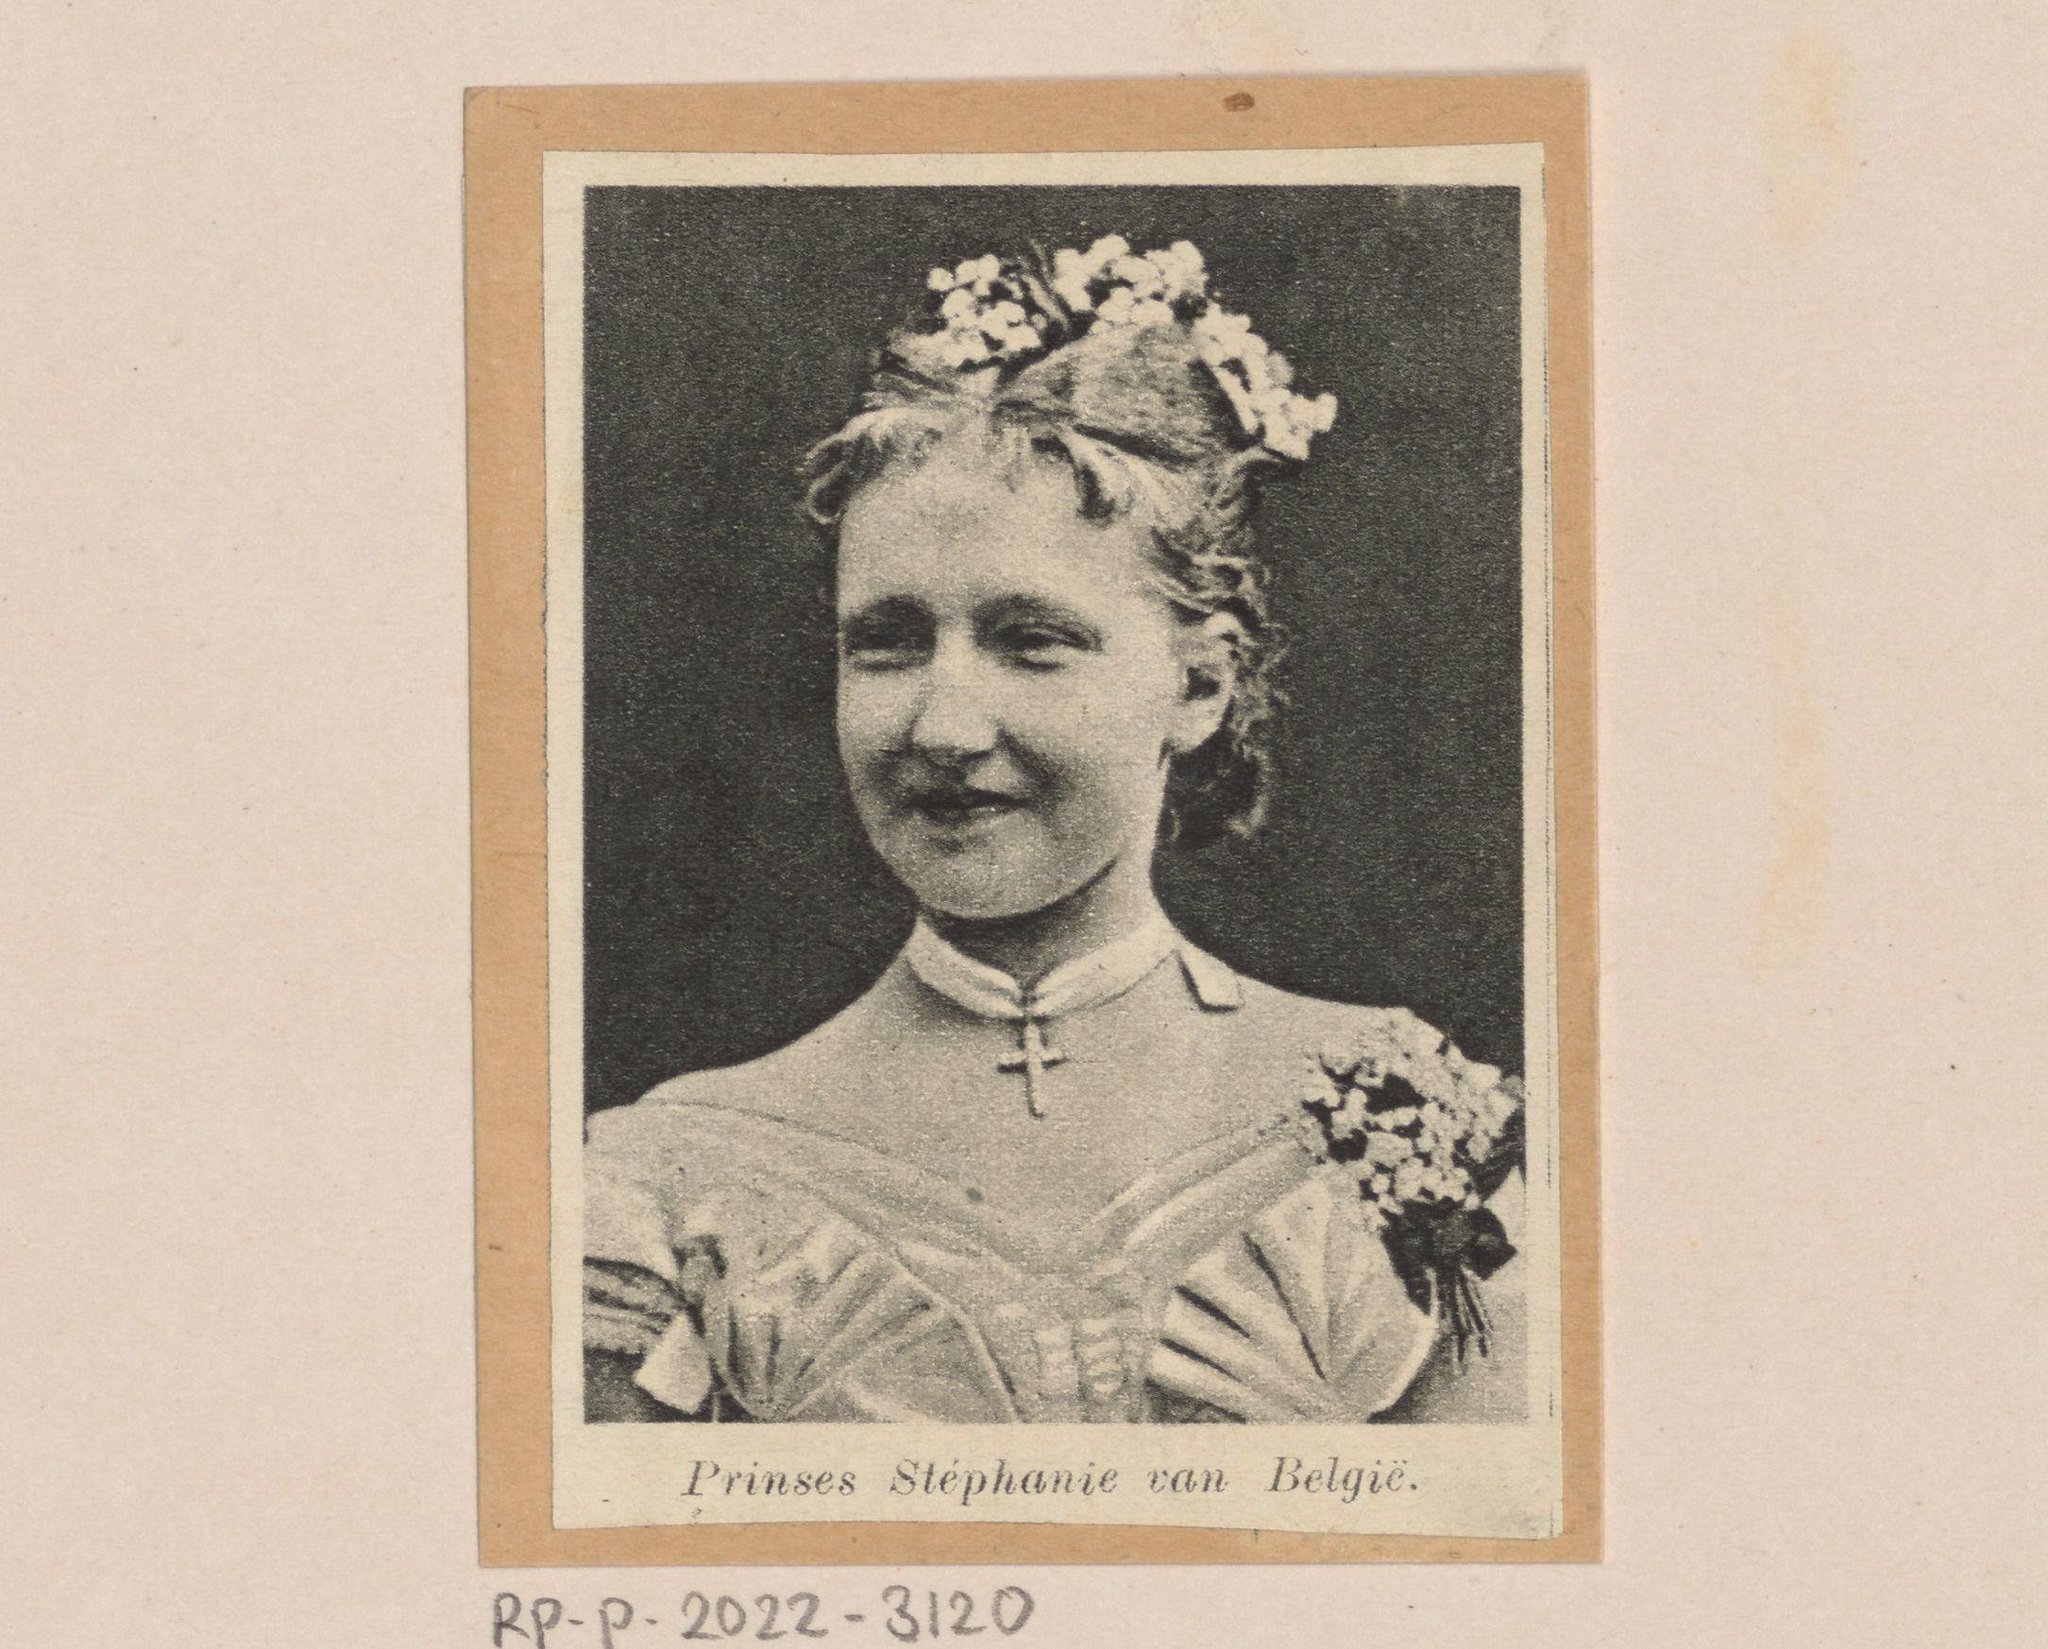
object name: photomechanical print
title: Portret van Stefanie van België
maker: Anonymous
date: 1881-1915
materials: paper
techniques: rotogravure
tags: brussels, crown princess, historical persons